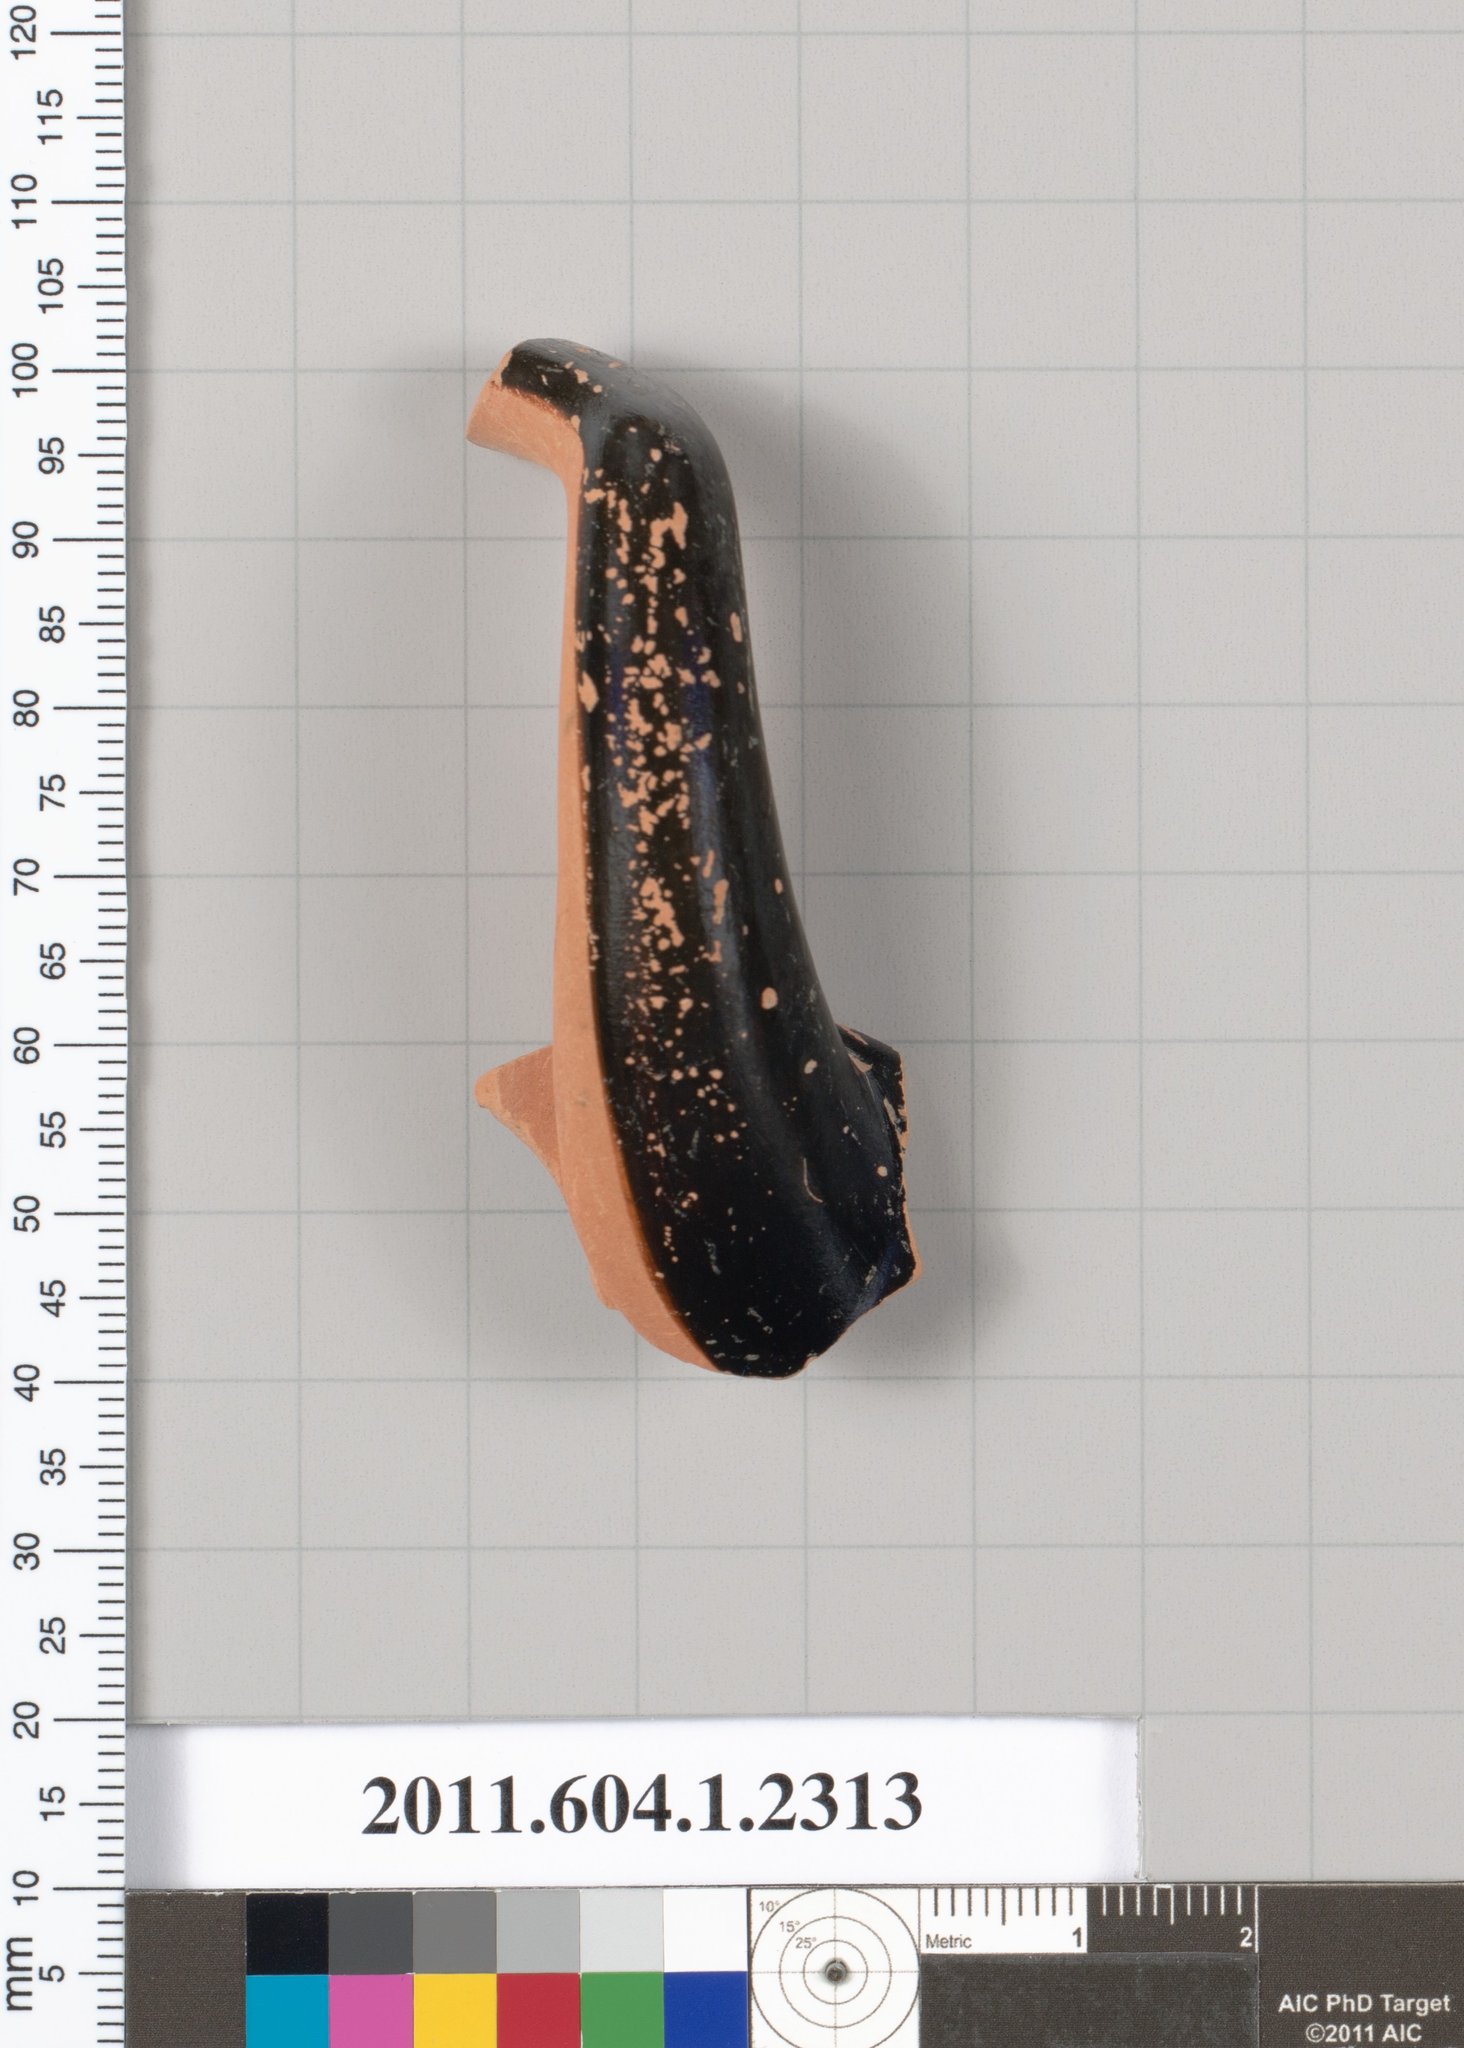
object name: kylix fragment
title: Terracotta fragment of a kylix (drinking cup)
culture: greek, attic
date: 500-451 BCE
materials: terracotta